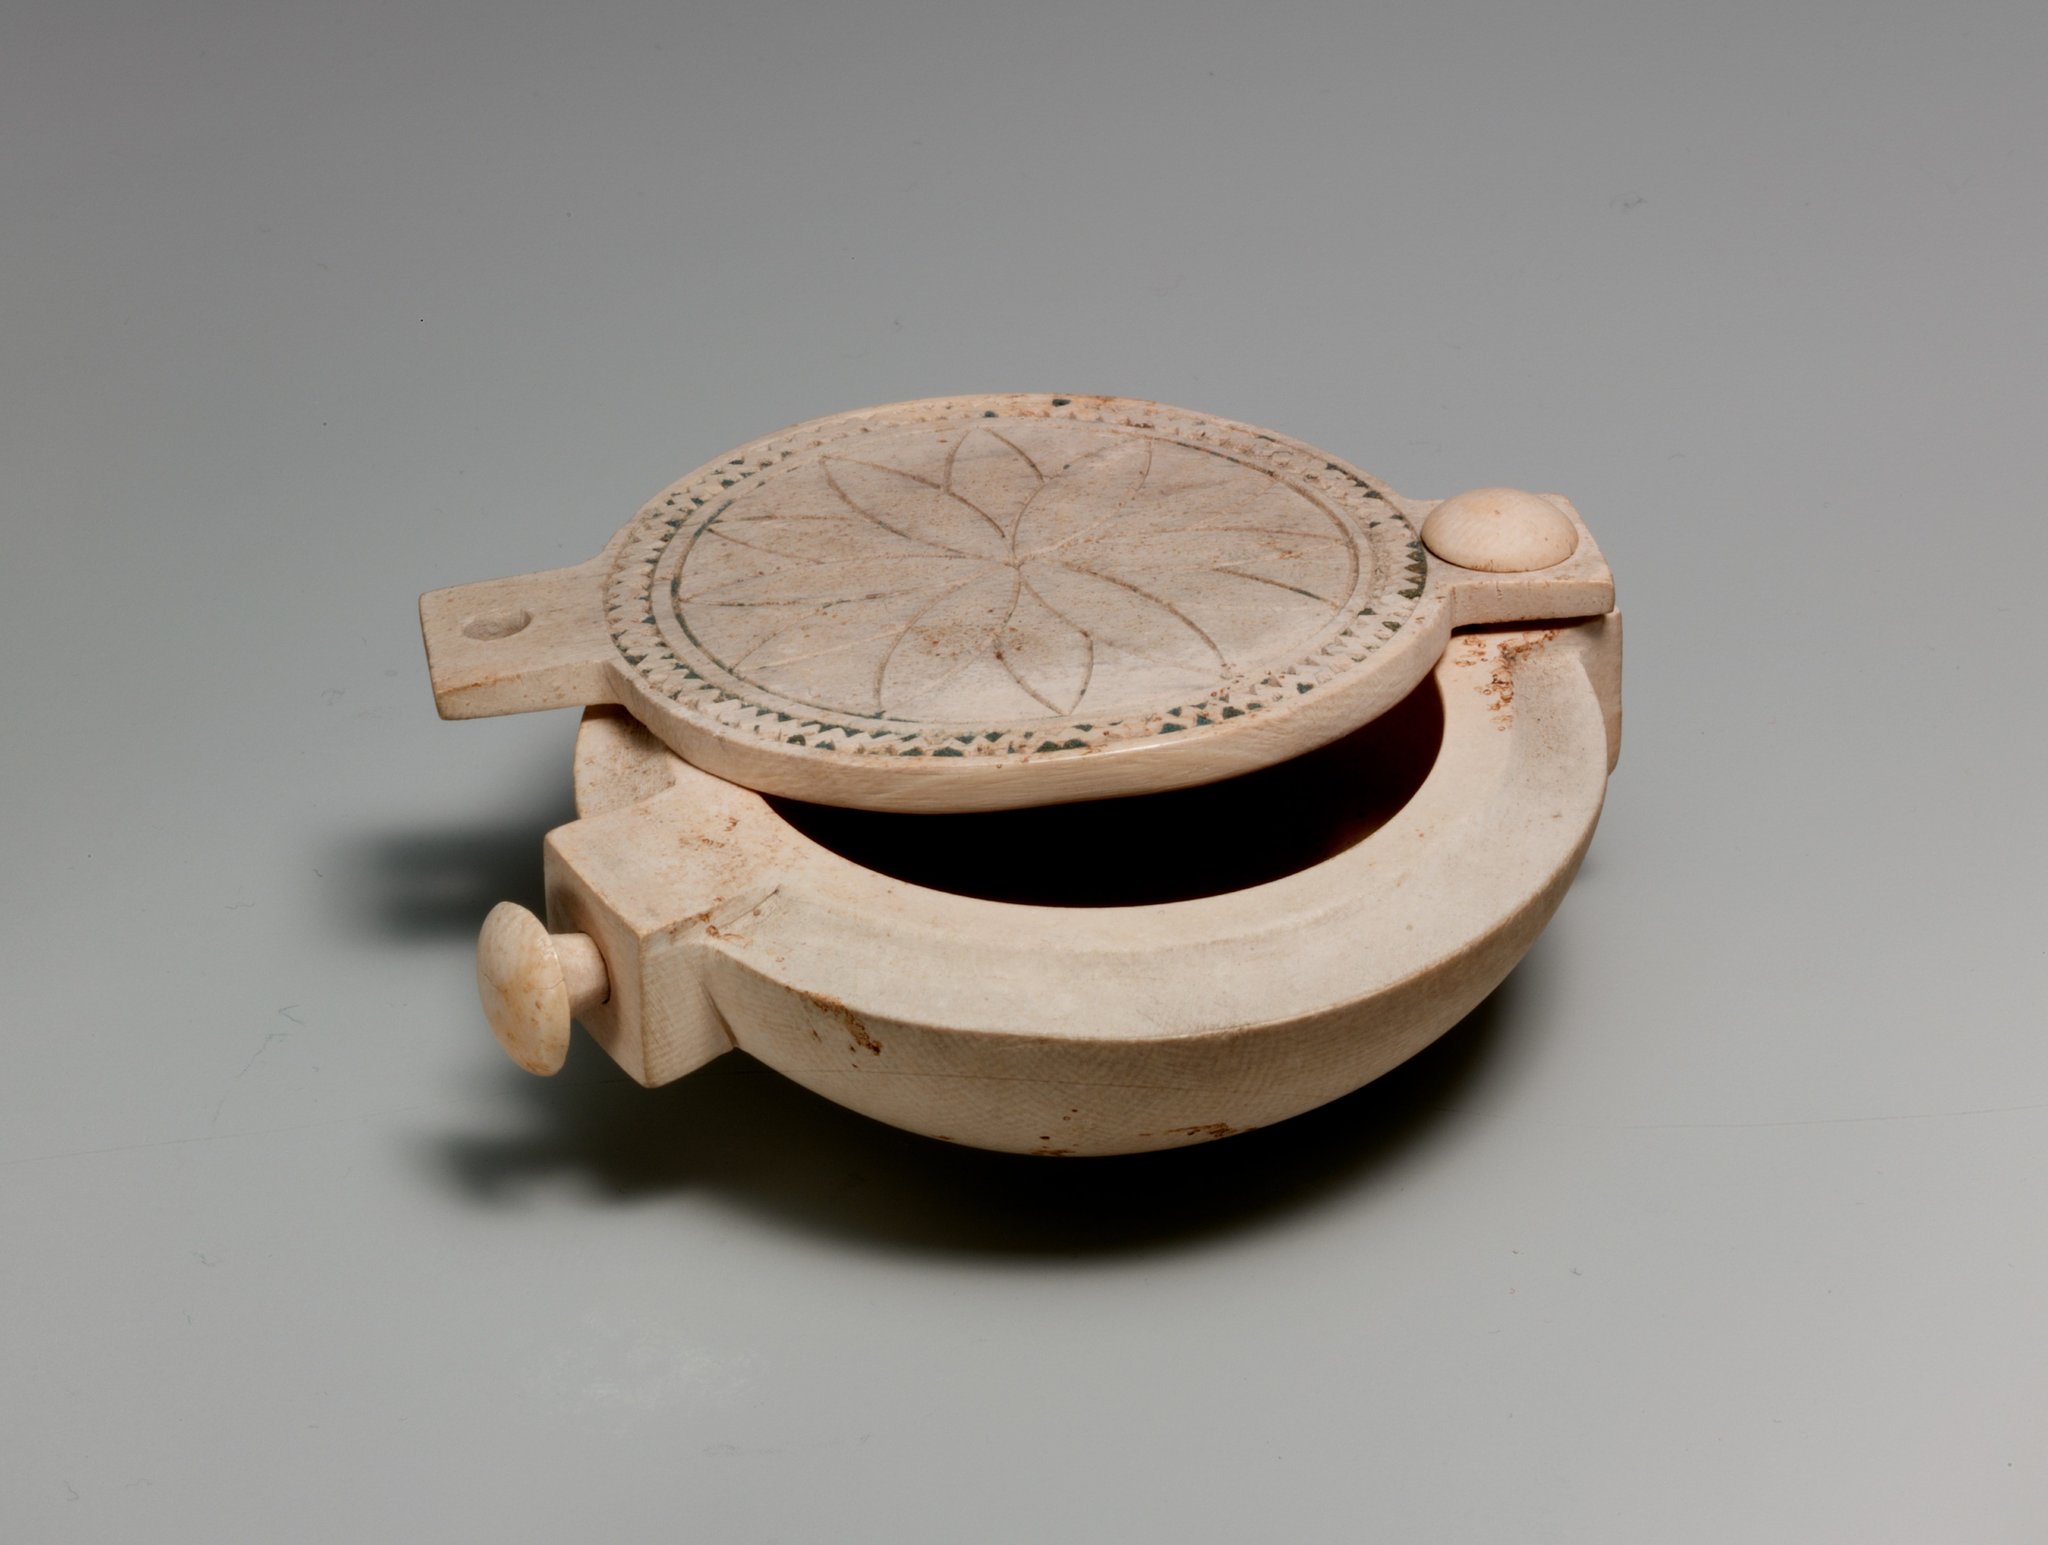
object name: cosmetic box, swivel top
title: Cosmetic Box with a Swivel Top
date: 1550-1458 BCE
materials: ivory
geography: egypt